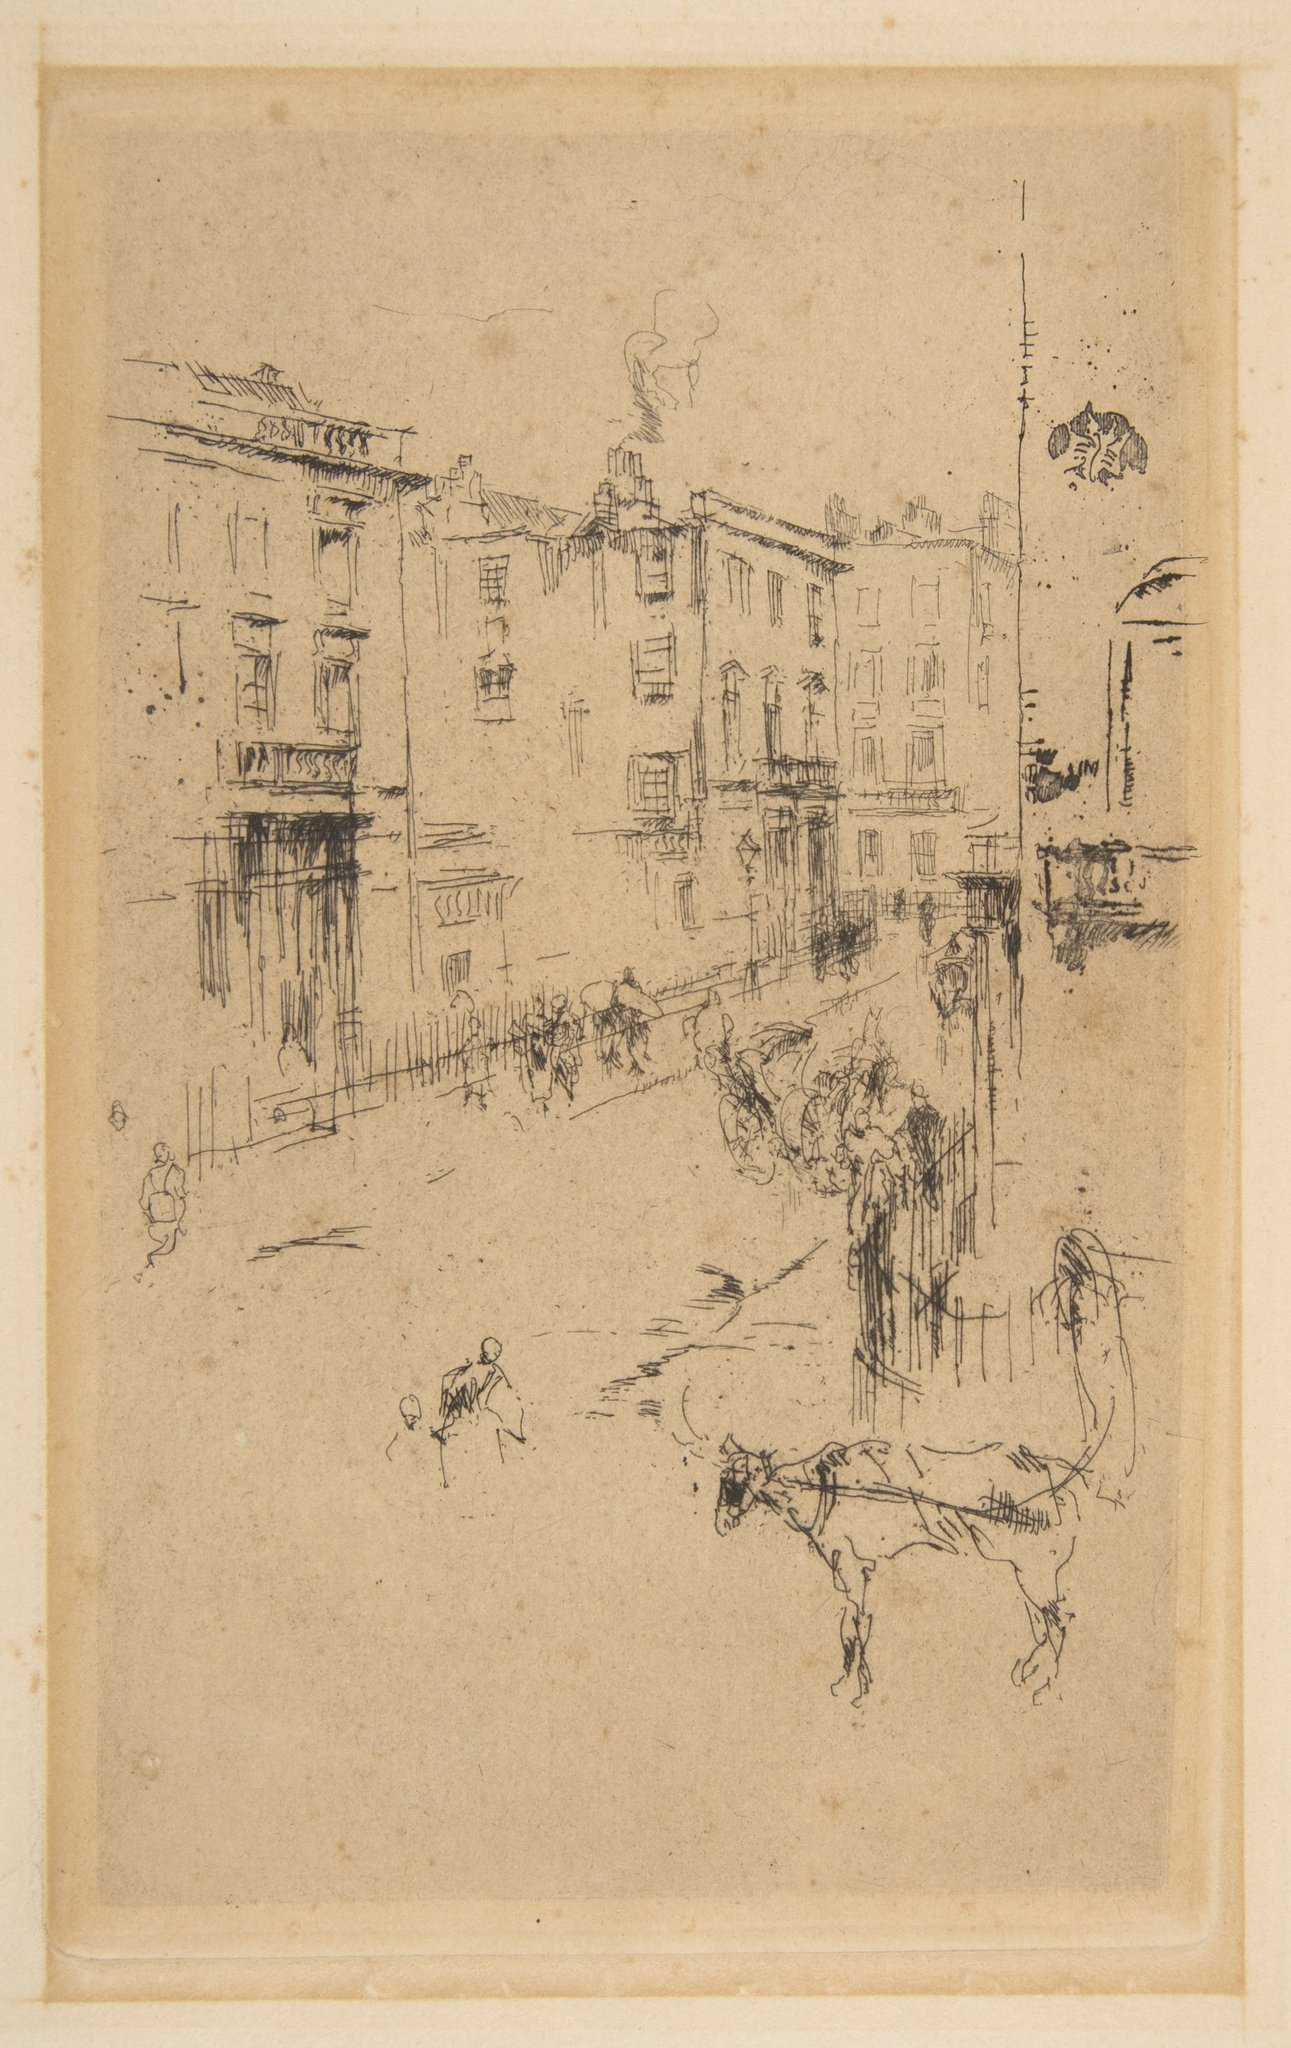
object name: print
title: Alderney Street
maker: james mcneill whistler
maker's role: artist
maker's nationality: american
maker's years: 1834-1903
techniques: etching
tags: animals,buildings,streets,london